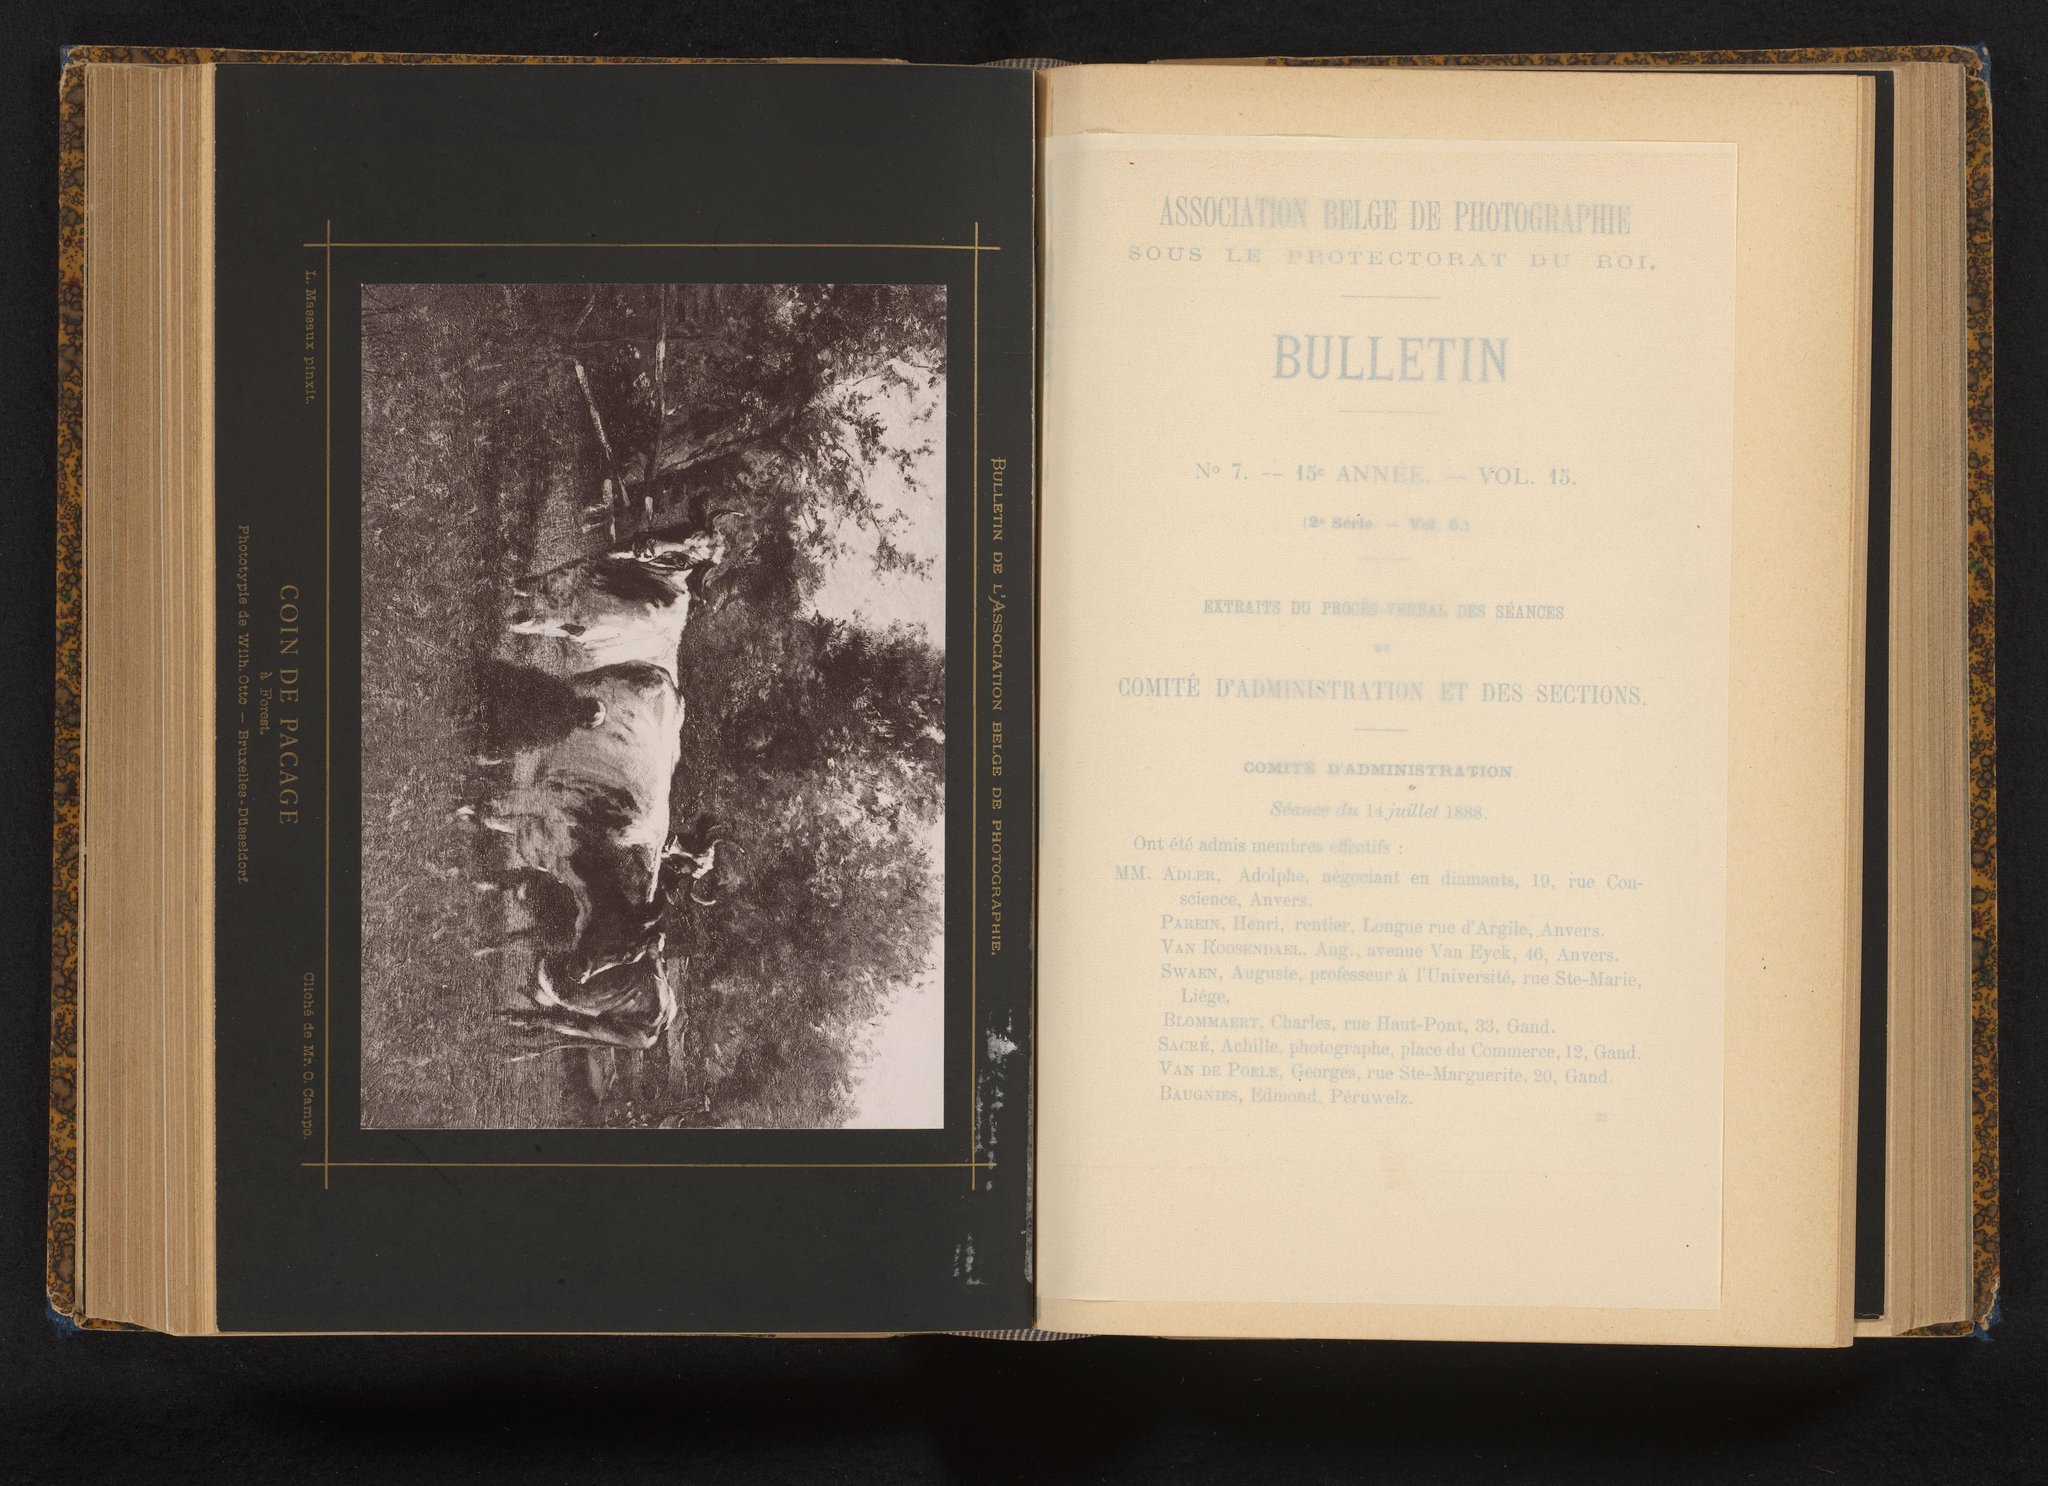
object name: page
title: Coin de pacage à Forest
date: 1883-1888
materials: cardboard, paper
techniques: photograph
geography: brussels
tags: cow, milking